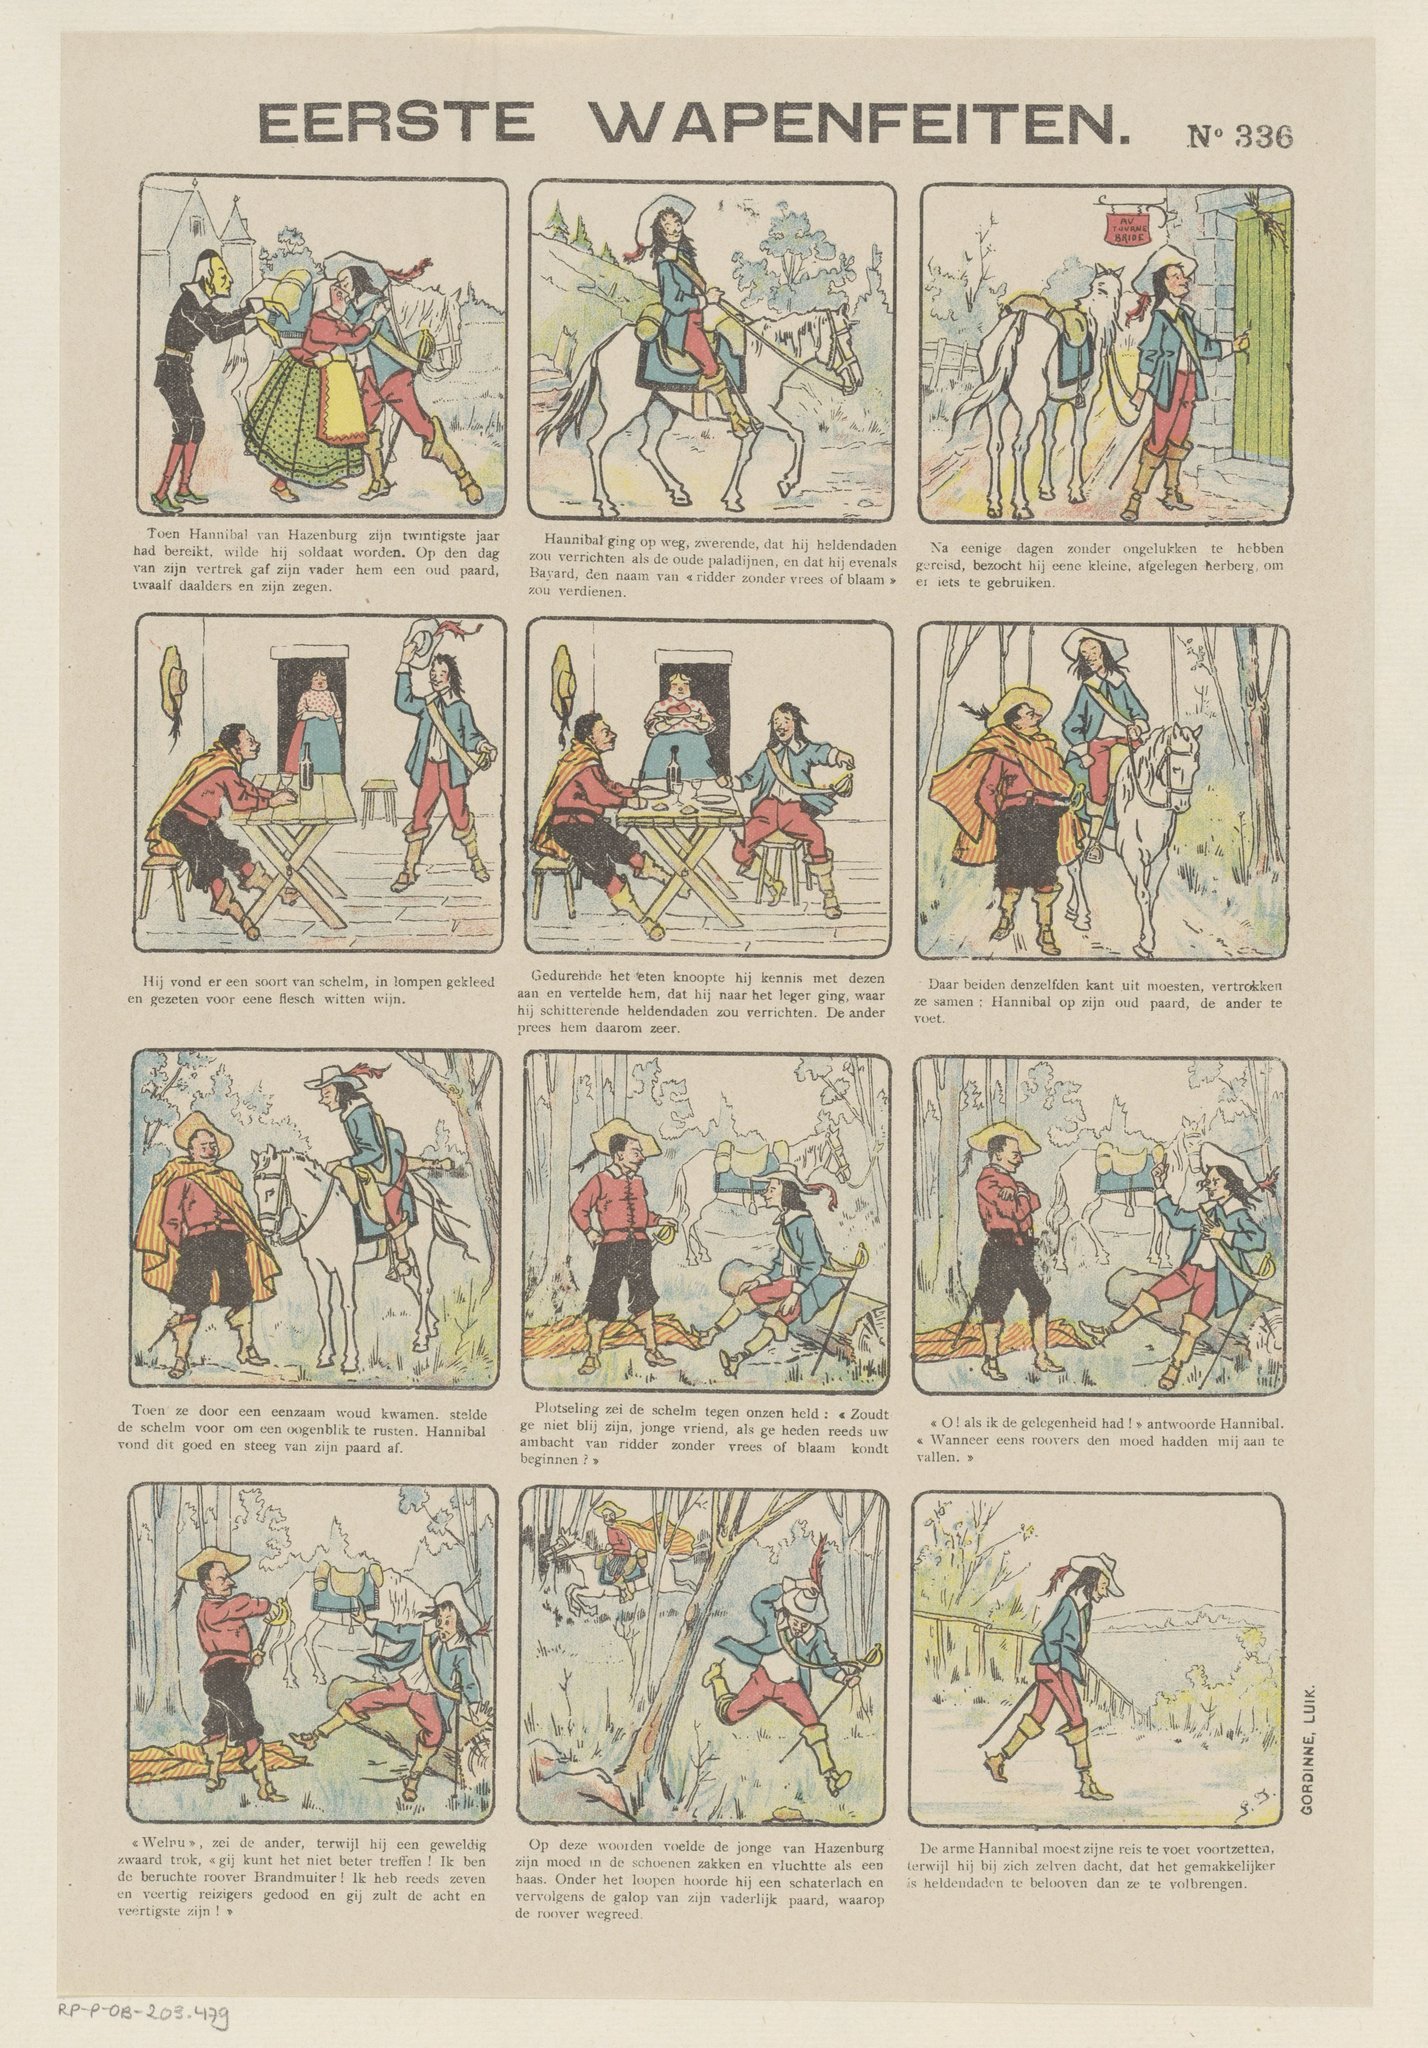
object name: popular print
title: Eerste wapenfeiten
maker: monogrammist g.j.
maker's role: print maker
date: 1894-1959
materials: paper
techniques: lithograph, letterpress printing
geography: liège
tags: theft, the soldier; the soldier's life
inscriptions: collector's mark: Lugt 2760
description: Blad met 12 voorstellingen over Hannibal van Hazenburg die soldaat wil worden. Onderweg naar het leger wordt hij beroofd van zijn paard. Onder elke afbeelding een onderschrift. Genummerd rechtsboven: No 336.